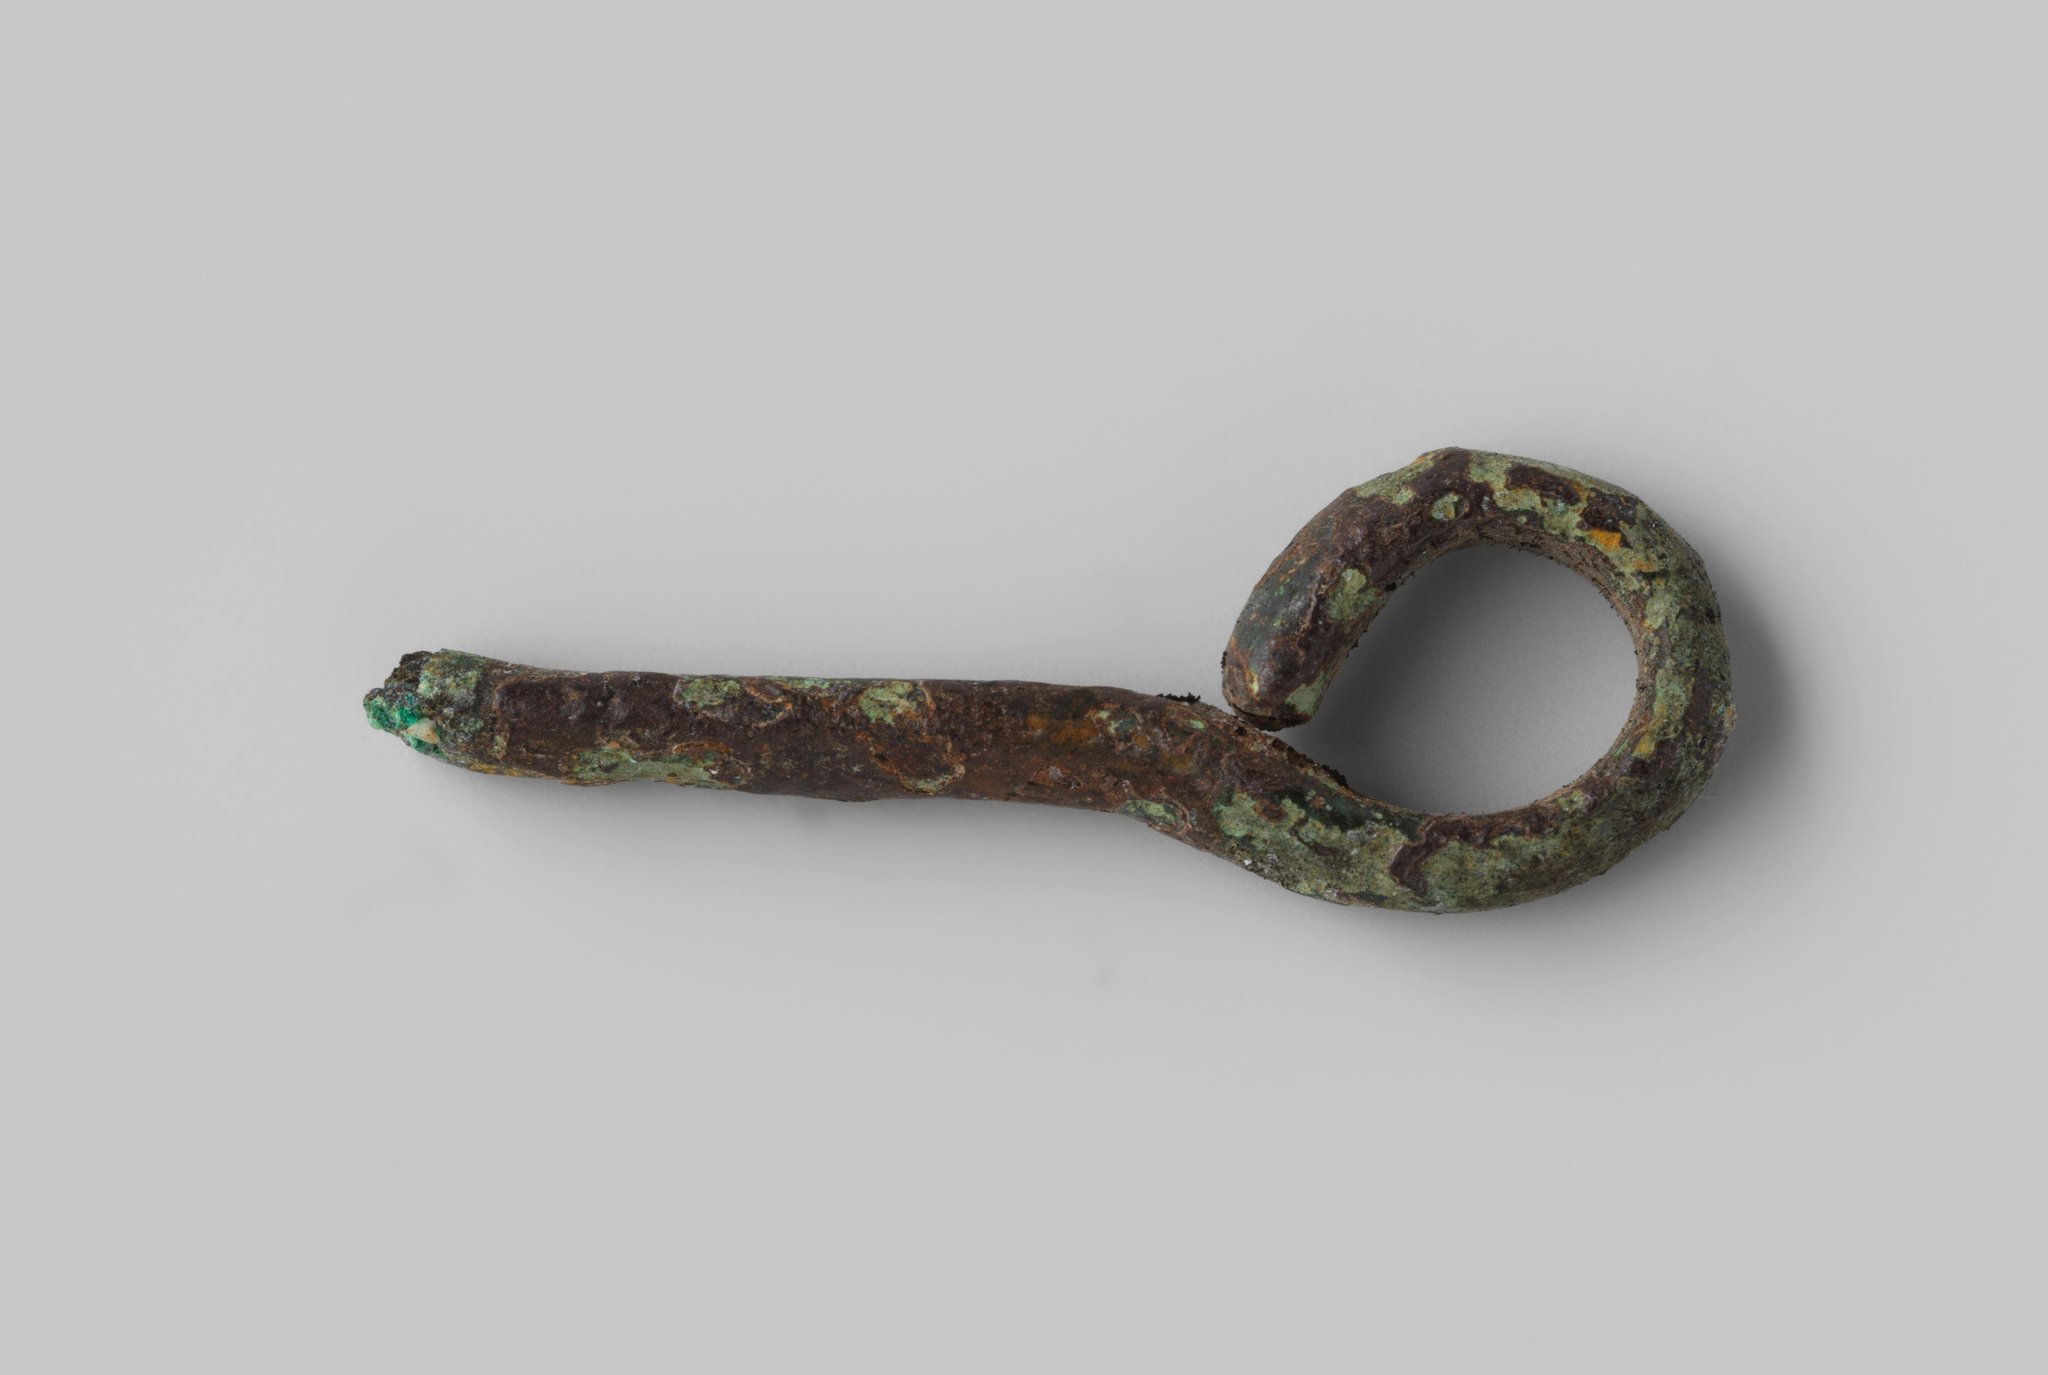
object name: spike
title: Pin van een gesp uit het wrak van de Oost-Indiëvaarder Hollandia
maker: Anonymous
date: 1700-1743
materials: copper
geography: netherlands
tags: verenigde oostindische compagnie, hollandia (schip), annet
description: Buckle, tongue; looped wire, pointed end, id. buckles NG 1980-27H384, NG 1980-27H2796, NG 1980-27H2610.